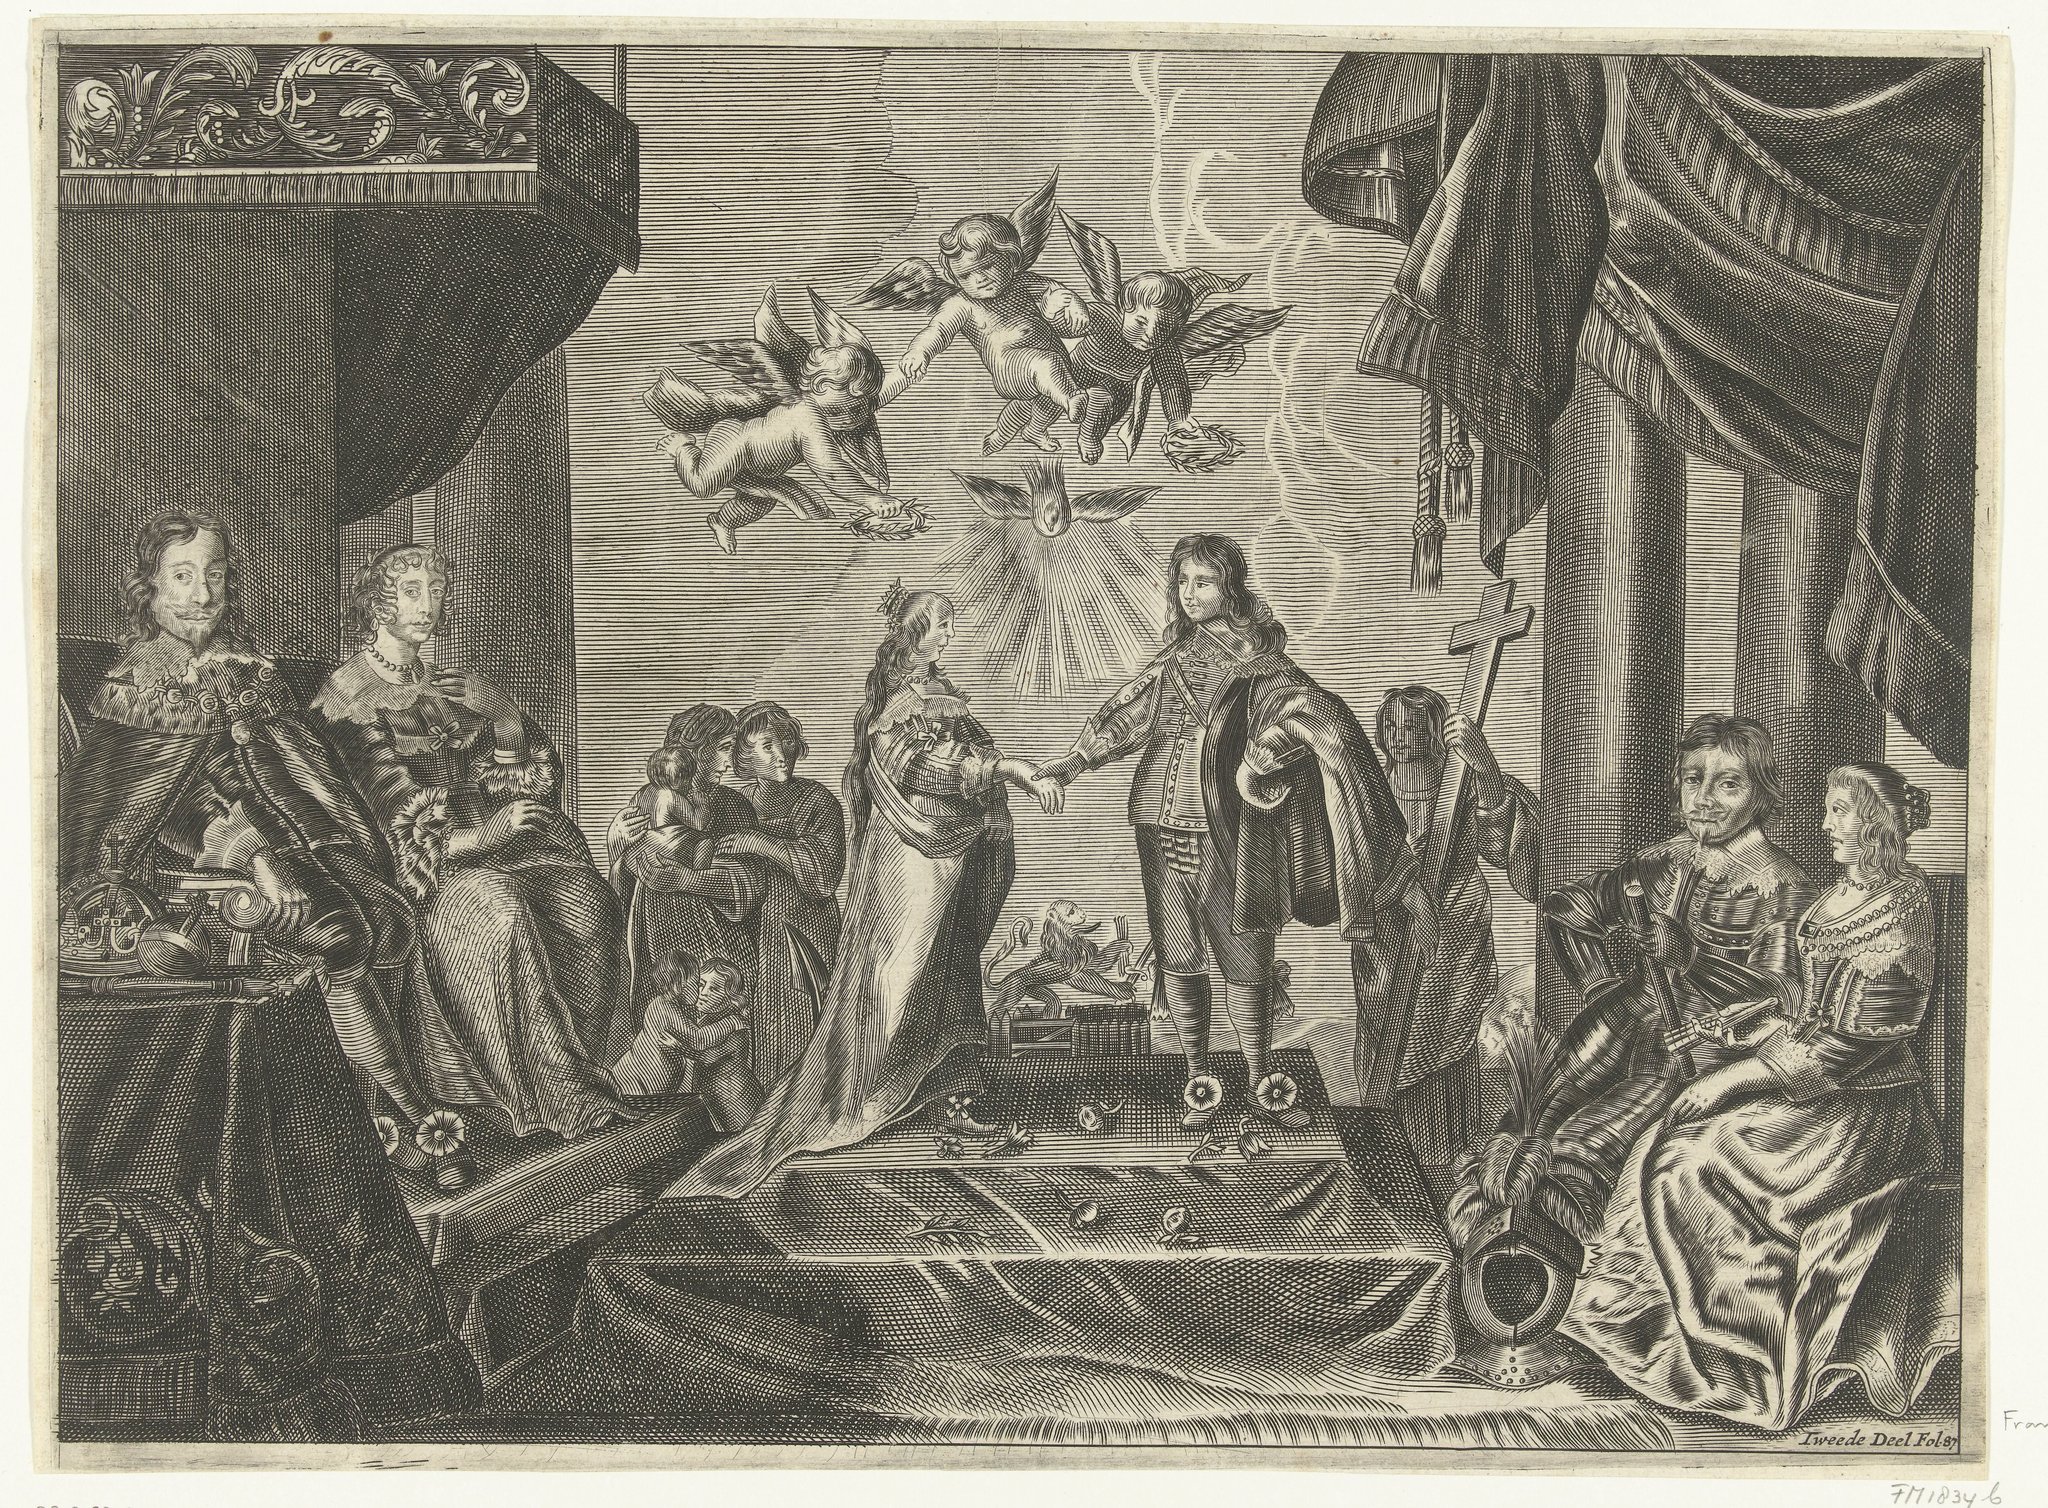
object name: history print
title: Huwelijk van prins Willem II en Maria Stuart, 1641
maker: Anonymous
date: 1651-1652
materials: paper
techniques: engraving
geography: northern netherlands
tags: henriëtta maria van frankrijk (koningin van engeland, schotland en ierland), delft, frederick henry (prince of orange), william ii (prince of orange), amalia of solms-braunfels, london, mary henrietta stuart, karel i (koning van engeland), marriage, married couple, 'matrimonium'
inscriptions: collector's mark: Lugt 963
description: Het huwelijk van prins Willem II en prinses Maria Stuart, 2 mei 1641. Links de ouders van de bruid: de Engelse koning Karel I en zijn vrouw Henrietta Maria. Rechts de ouders van de bruidegom: Frederik Hendrik en Amalia van Solms. Op de achtergrond allegorische figuren van Liefde en Hoop (links) en Geloof (rechts) en de Hollandse Leeuw in de Hollandse Tuin. Boven het paar de duif van de Heilige Geest en putti met lauwerkransen. Gemerkt rechtsonder: Tweede Deel Fol. 87.